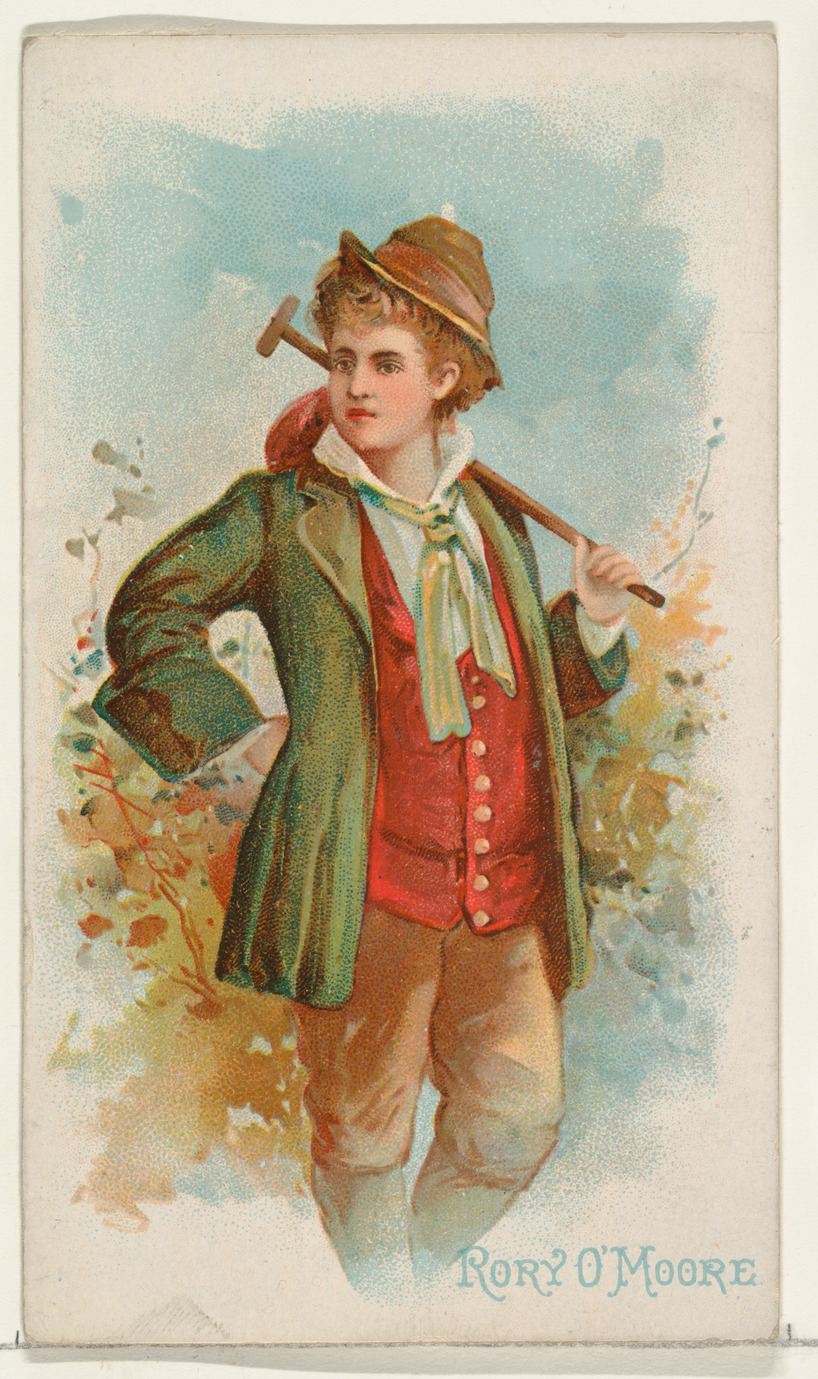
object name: print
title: Rory O'Moore, from the Illustrated Songs series (N116) issued by W. Duke, Sons & Co. to promote Honest Long Cut Tobacco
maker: w. duke, sons & co.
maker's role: publisher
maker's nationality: american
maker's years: 1870-1920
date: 1893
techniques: color lithograph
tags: women